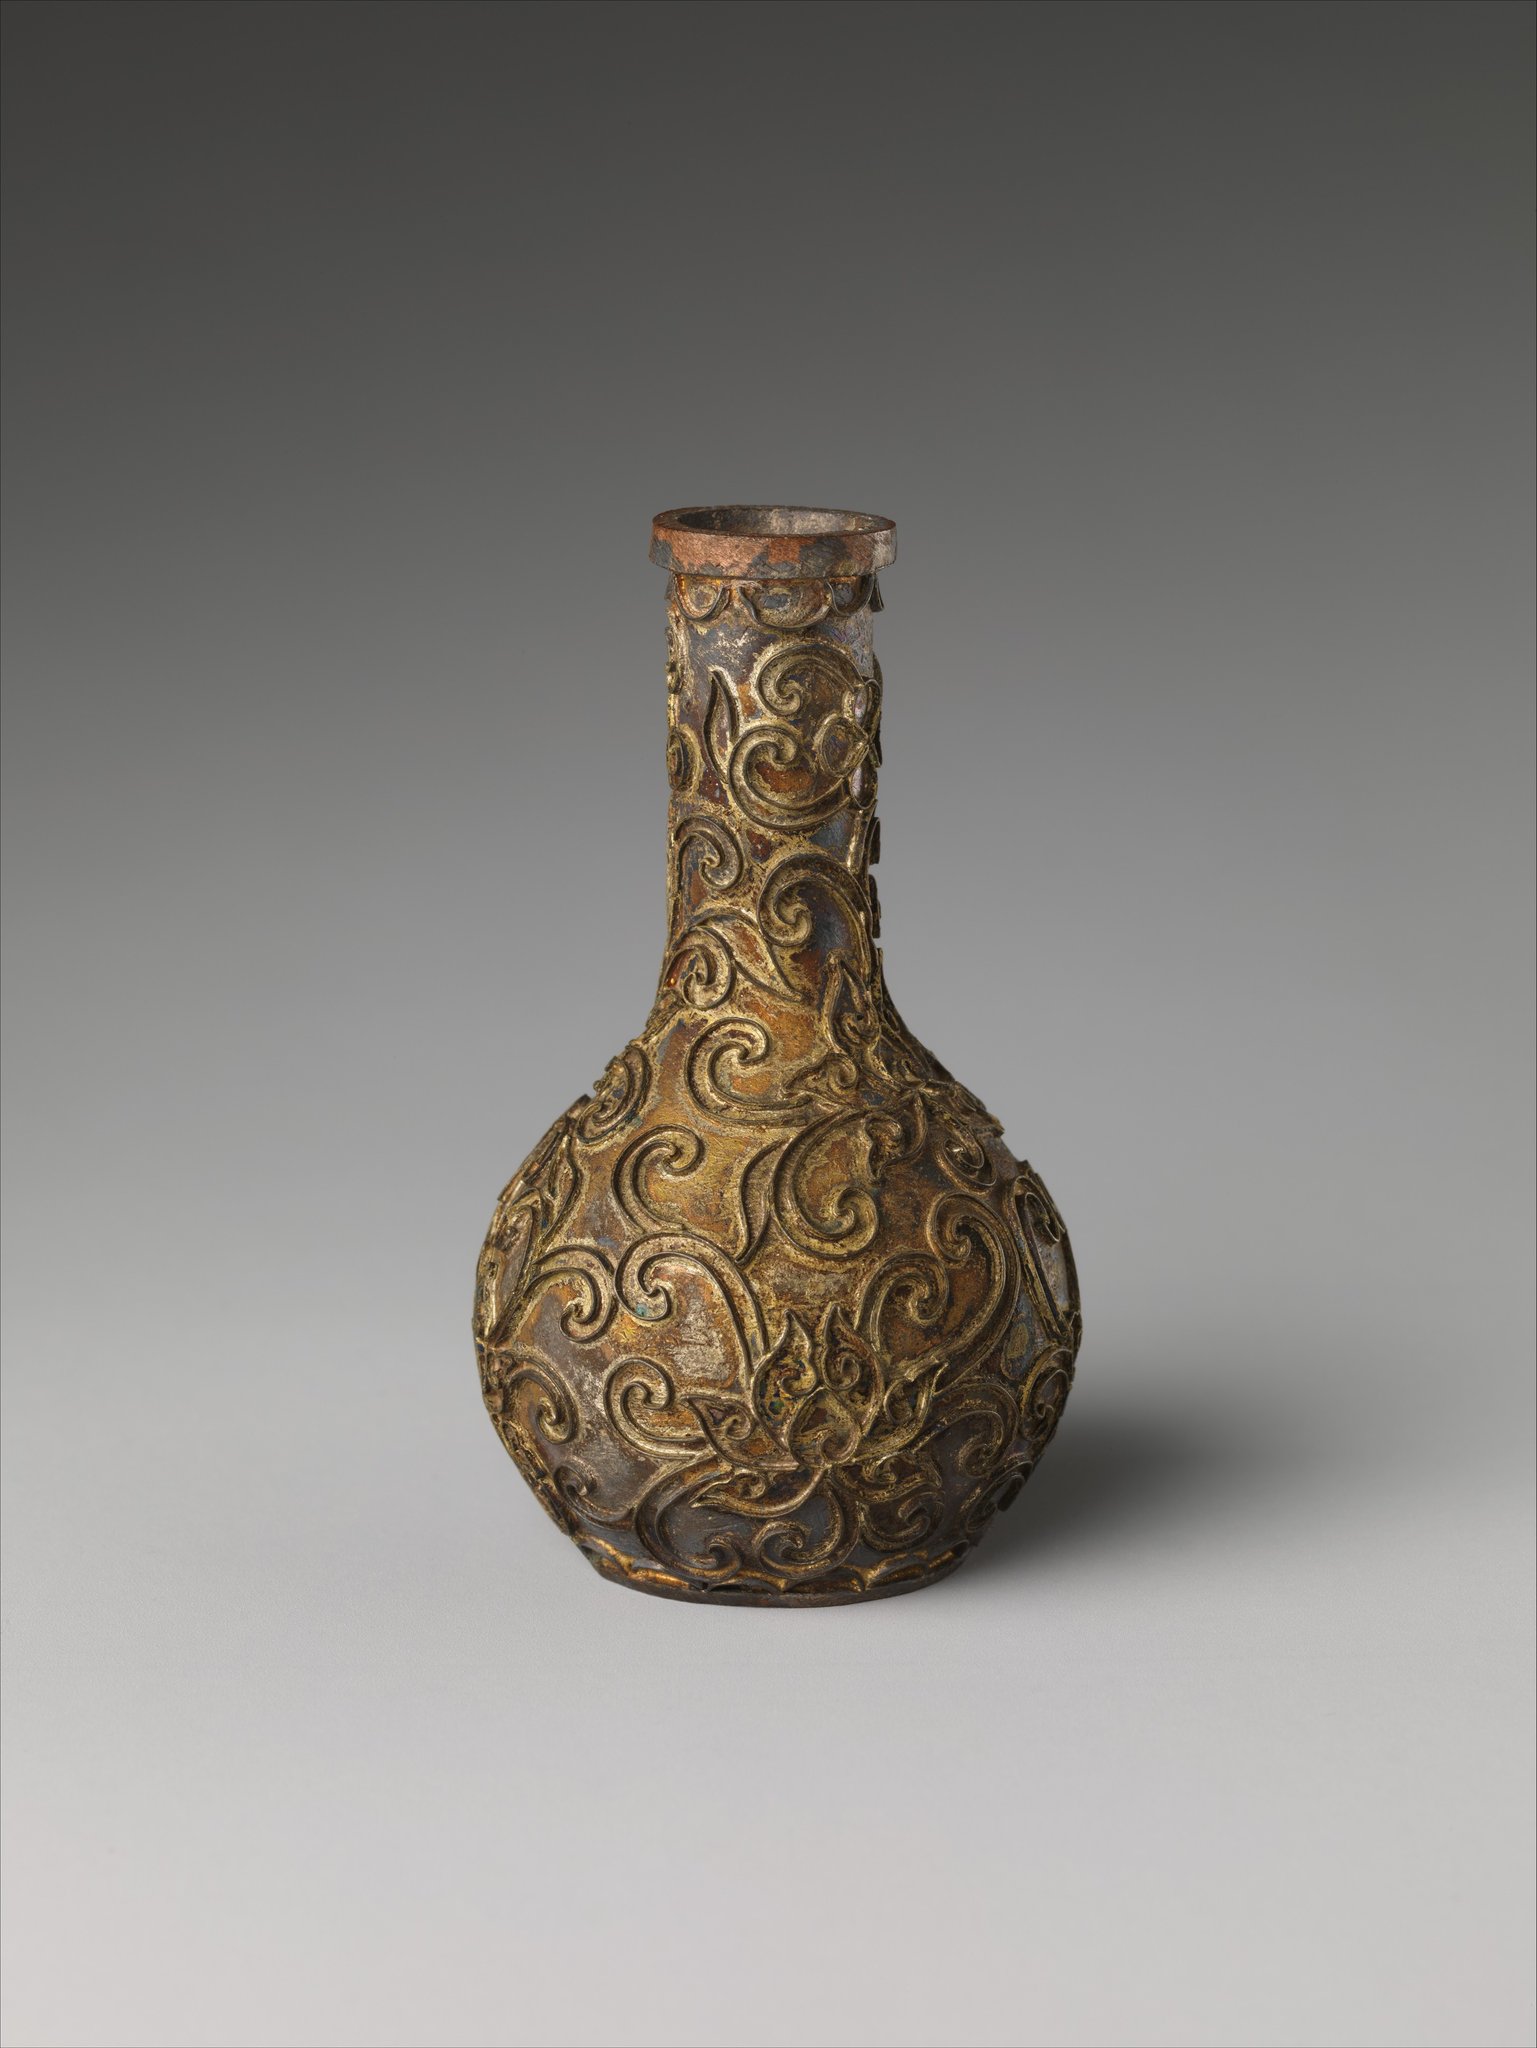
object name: vase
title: Vase from sample set of Chinese cloisonné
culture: chinese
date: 1867-1900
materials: copper alloy, enamel, glass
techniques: enamel